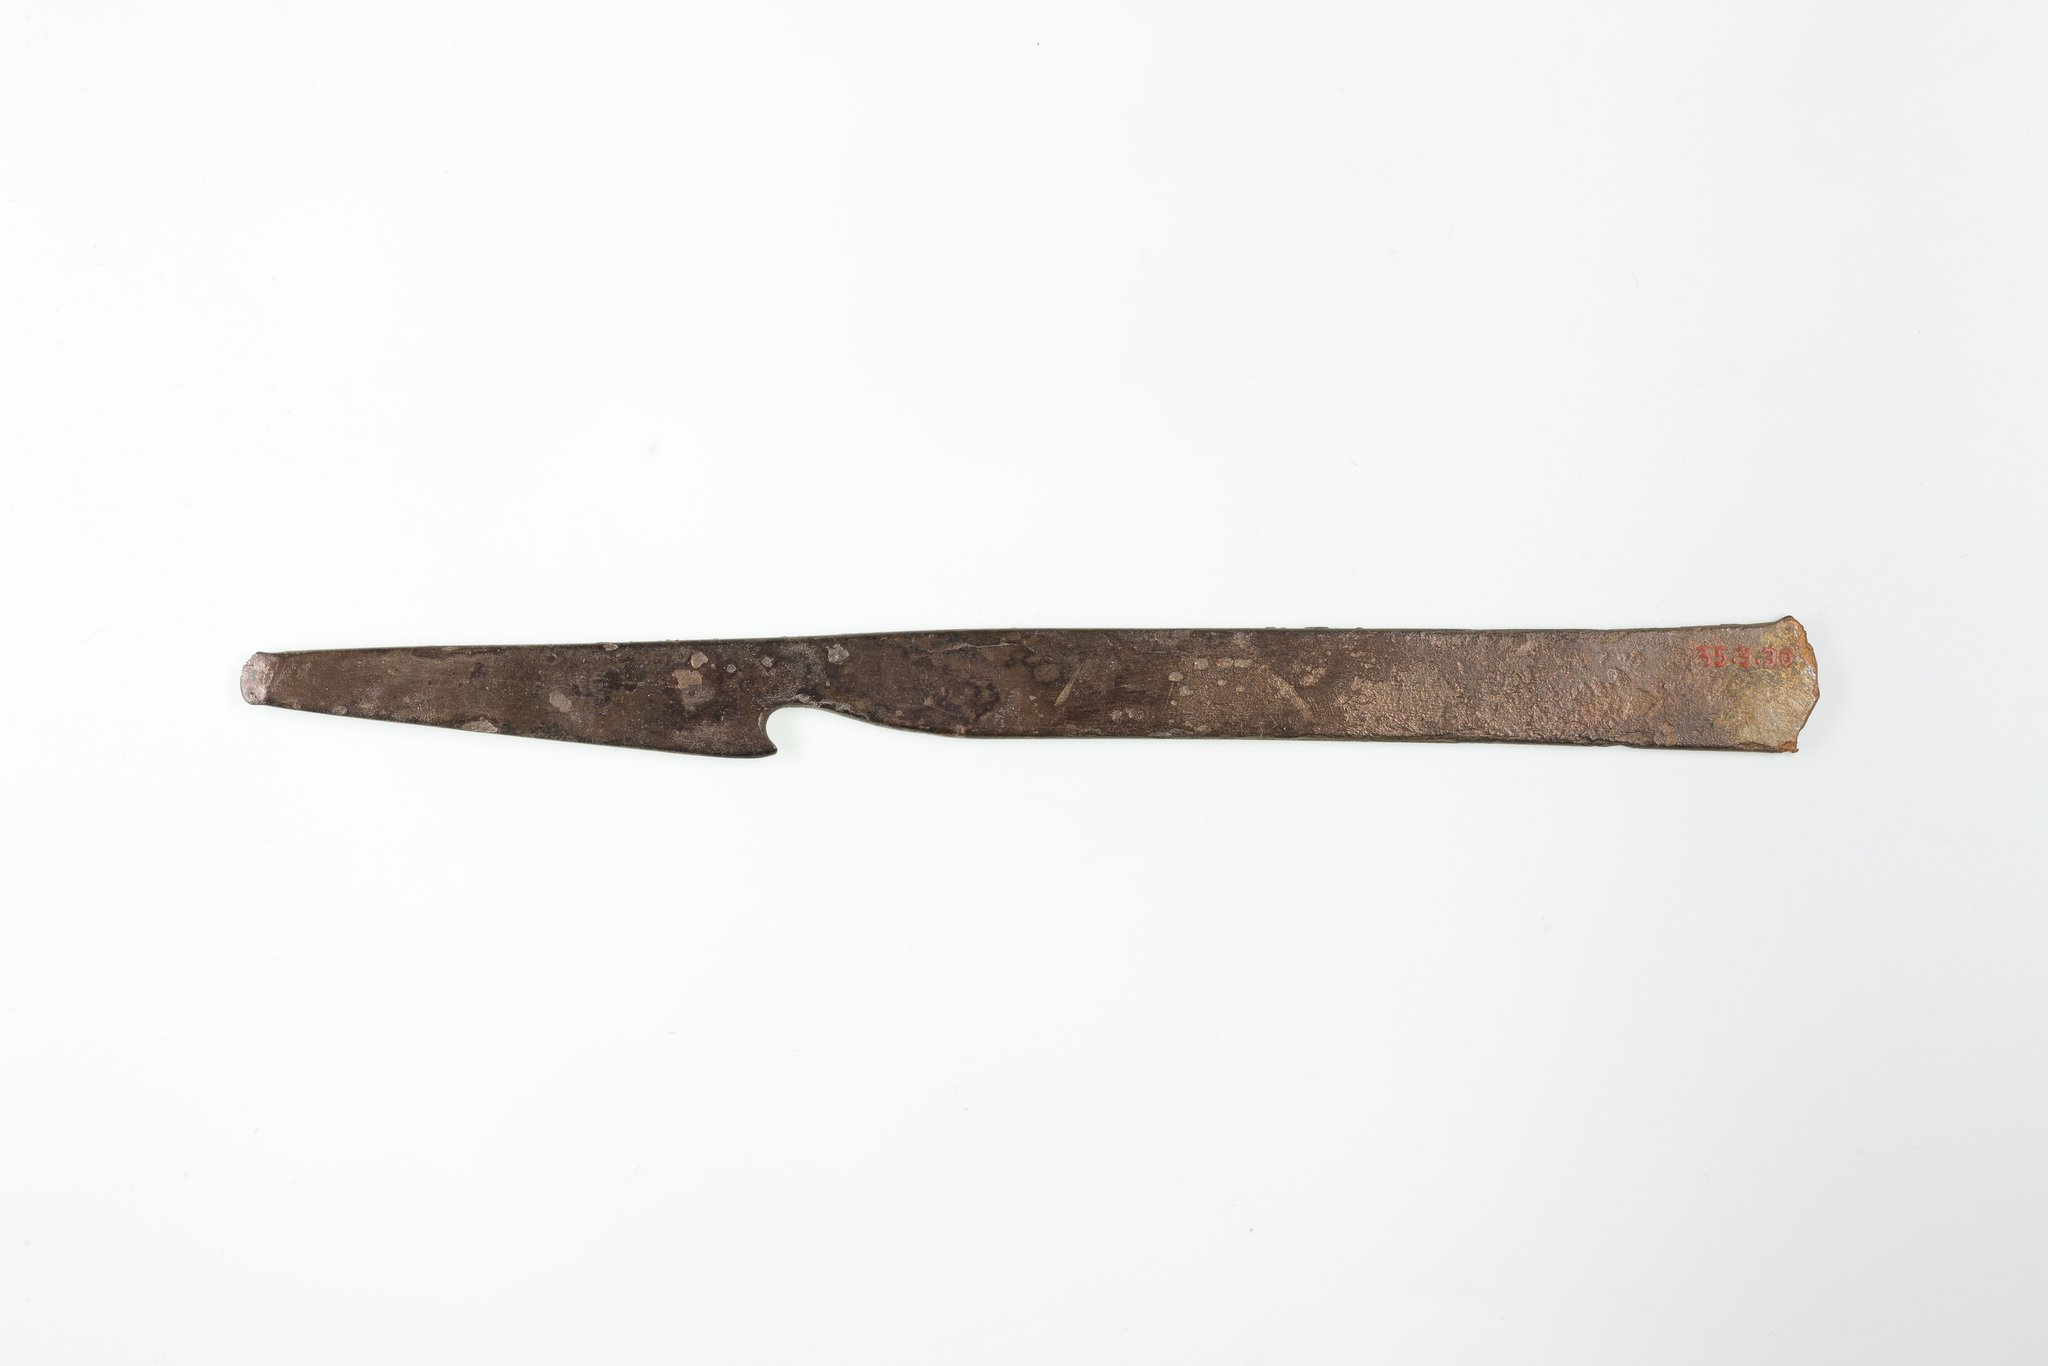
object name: razor knife, dega, amenemhat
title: Amenemhat's Razor-Knife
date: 1504-1447 BCE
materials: bronze, copper alloy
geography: egypt